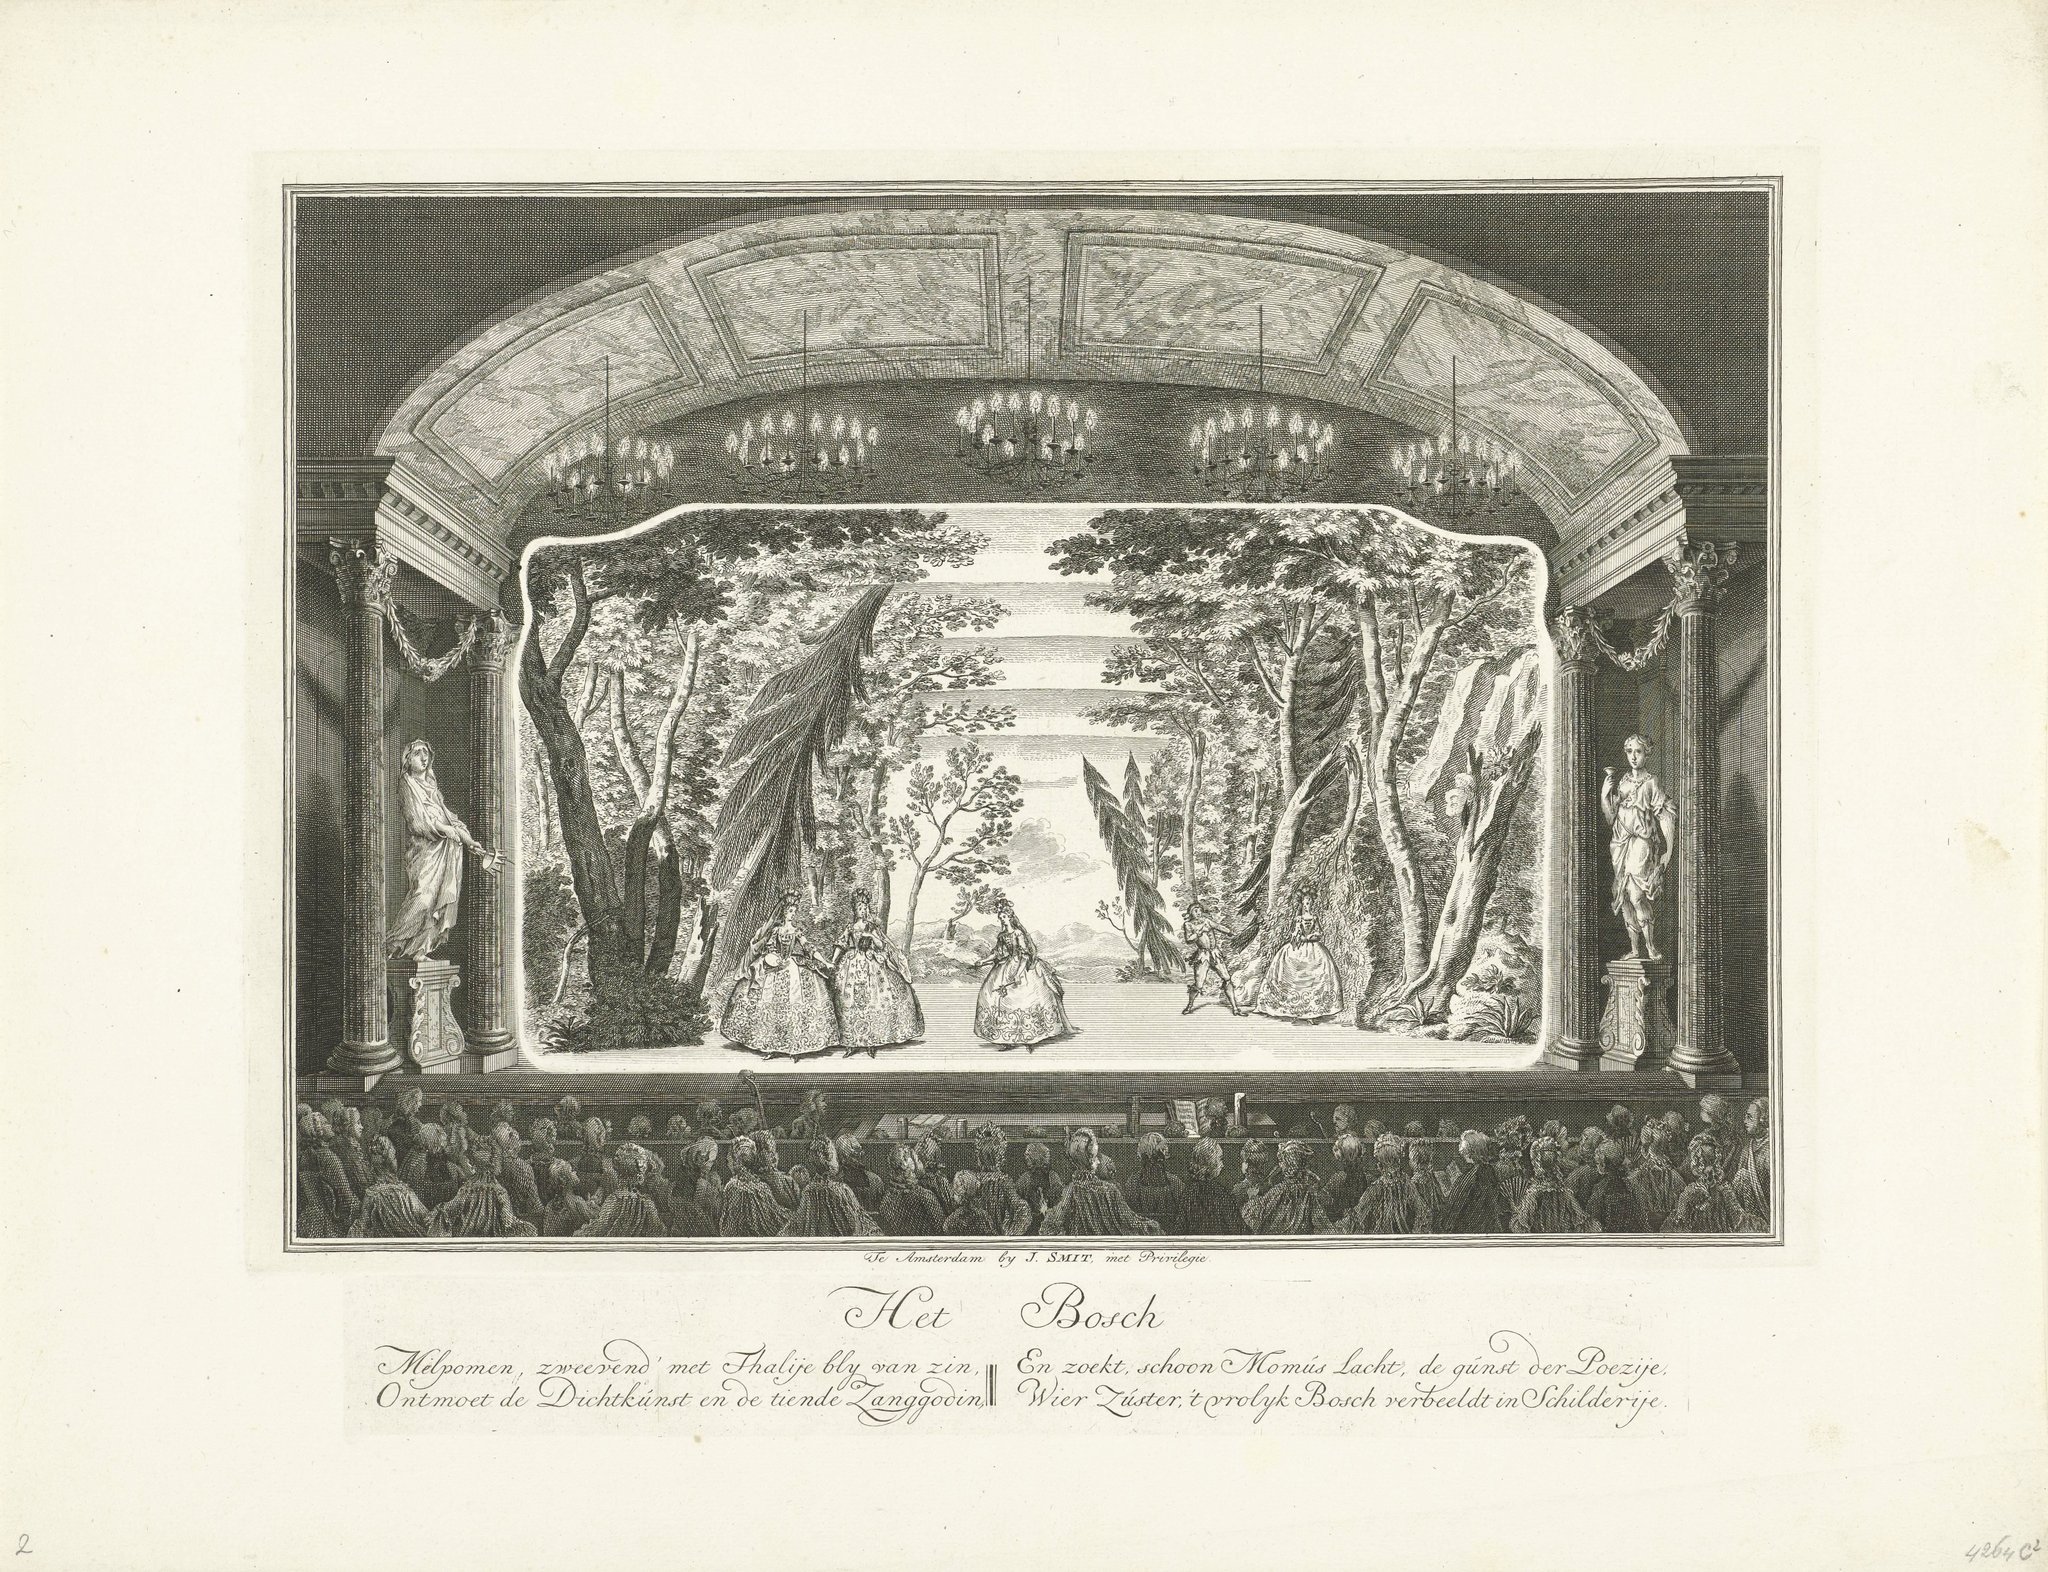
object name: print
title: Het Bosch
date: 1738-1740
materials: paper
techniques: engraving, etching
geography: amsterdam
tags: theatre, theatrical performance, stage design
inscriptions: collector's mark: Lugt 2228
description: Toneelvoorstelling in de Amsterdamse Schouwburg op de Keizersgracht met het coulissendecor Het Bosch met scène uit: Het Eeuwgetijde van den Amsteldamschen Schouwburg. Het decor gedrukt van een aparte plaat binnen een nieuw passe-partout met de zaal, orkestbak en de façade van het toneel met zuilen en kroonluchters. De titel en een vierregelig vers ook gedrukt van een aparte plaat. Onderdeel van een latere uitgave van de serie van 12 toneeldecors.